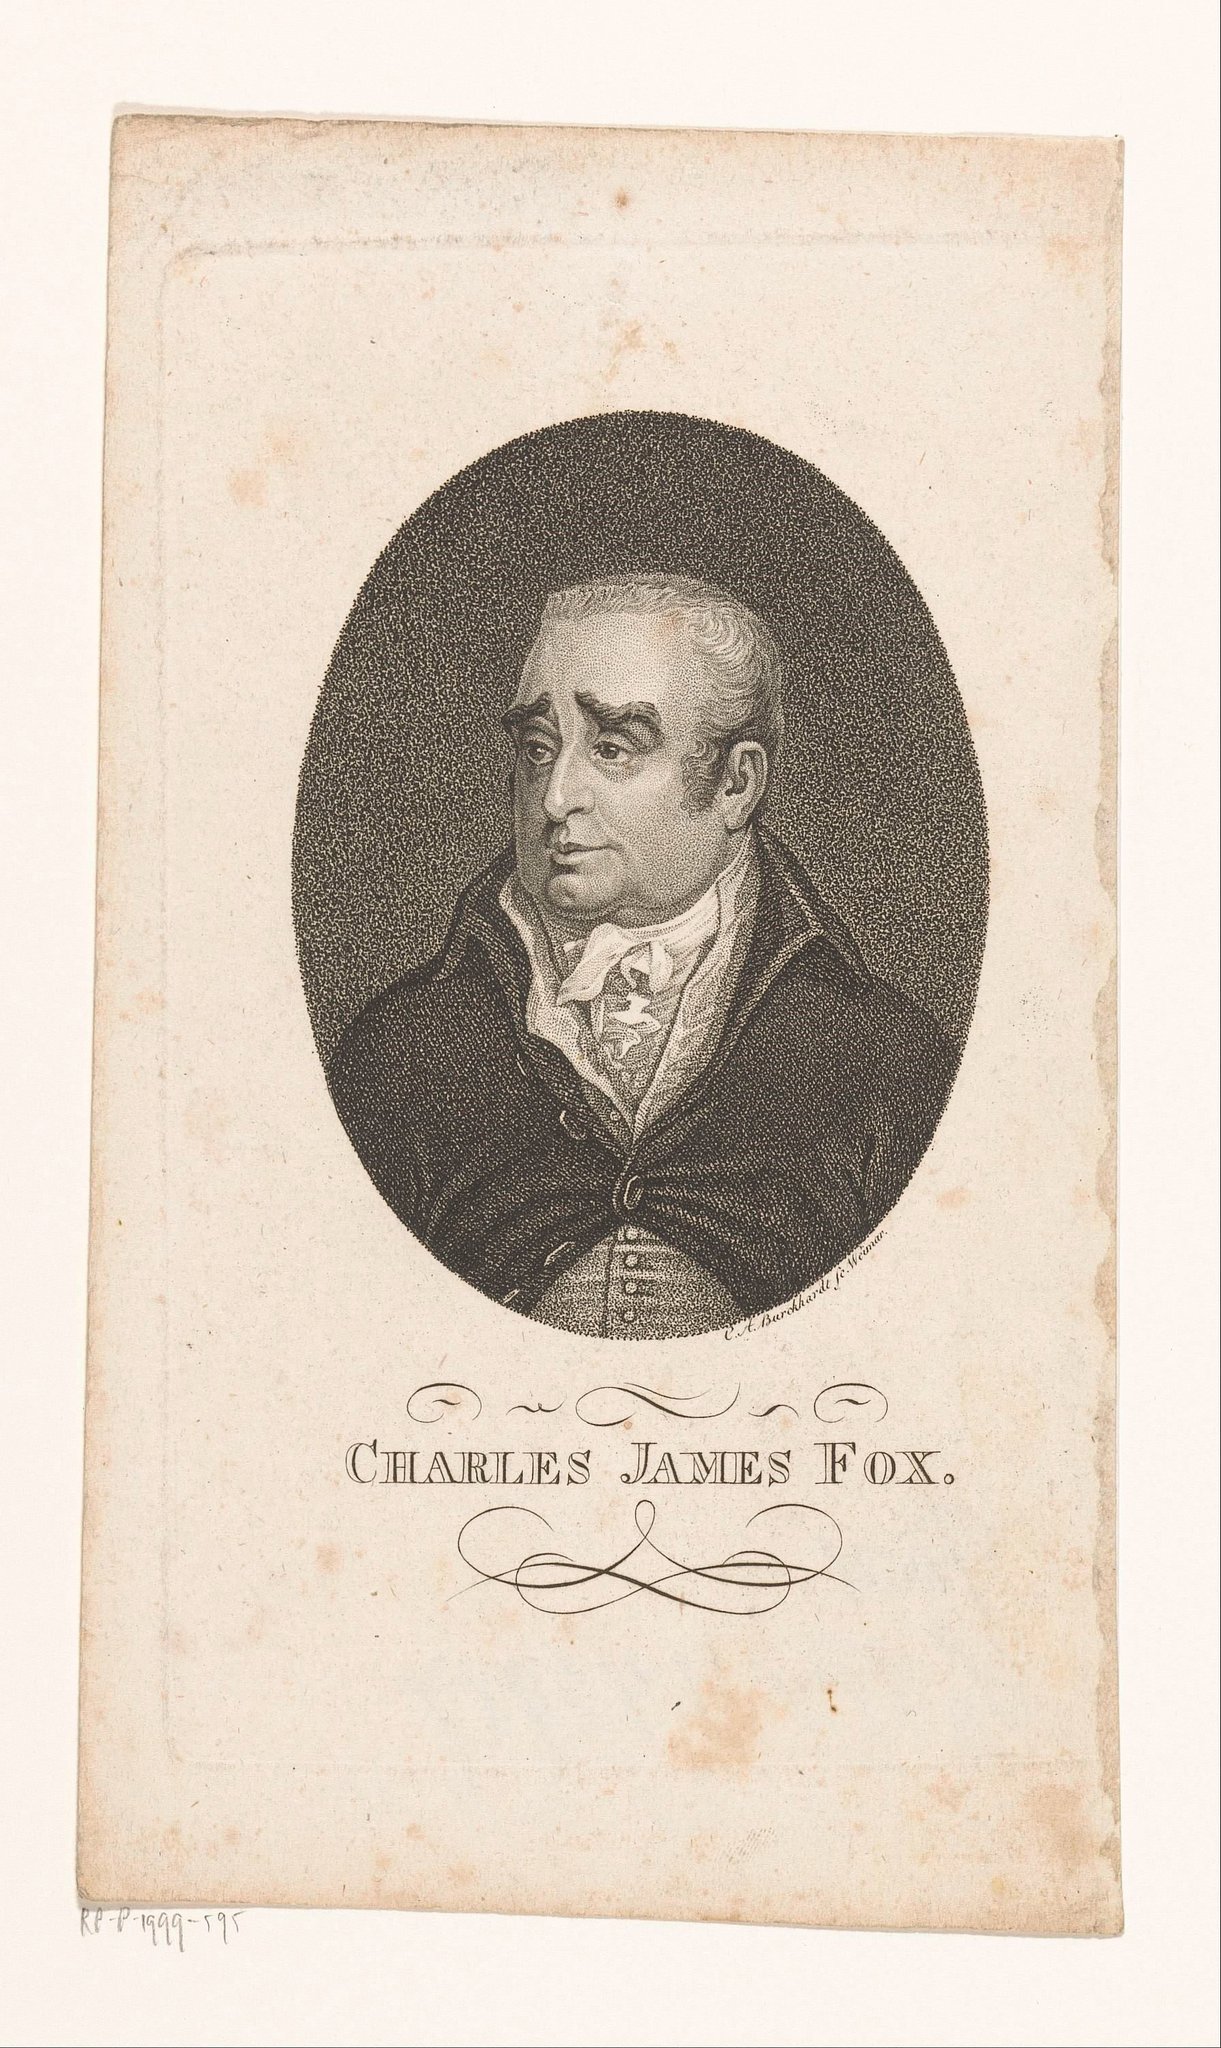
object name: print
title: Portret van Charles James Fox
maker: c.a. burckhardt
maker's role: print maker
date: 1775-1850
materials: paper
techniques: stippling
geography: weimar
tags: historical persons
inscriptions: collector's mark: Lugt 2228, collector's mark: Lugt 2228